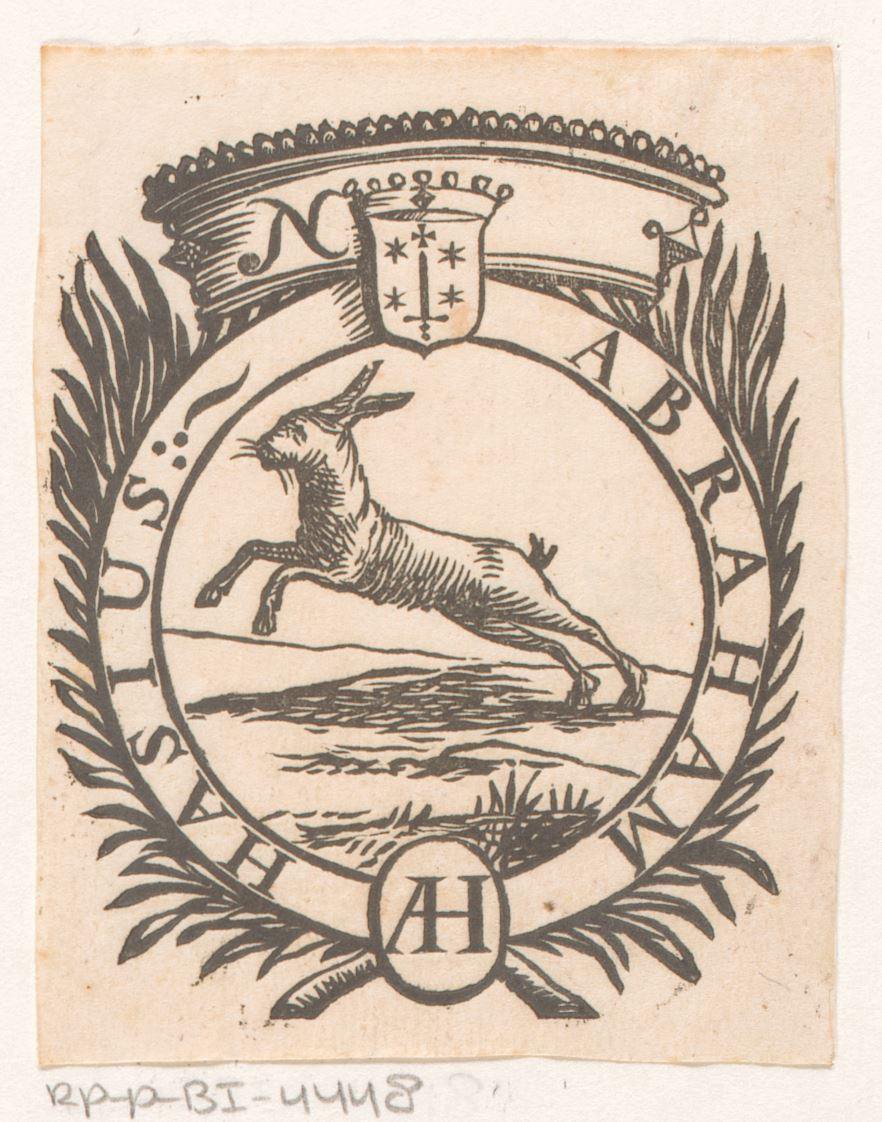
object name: print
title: Vignet van Abraham Hasius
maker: Anonymous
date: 1600-1699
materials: paper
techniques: woodcut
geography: netherlands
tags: coat of arms (as symbol of the state, etc.) (+ city; municipal), rodents: hare, vignette, haarlem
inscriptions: collector's mark: Lugt 240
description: Een haas in een cirkel met randschrift. Midden boven het wapen van de stad Haarlem. Midden onder het monogram van Abraham Hasius.